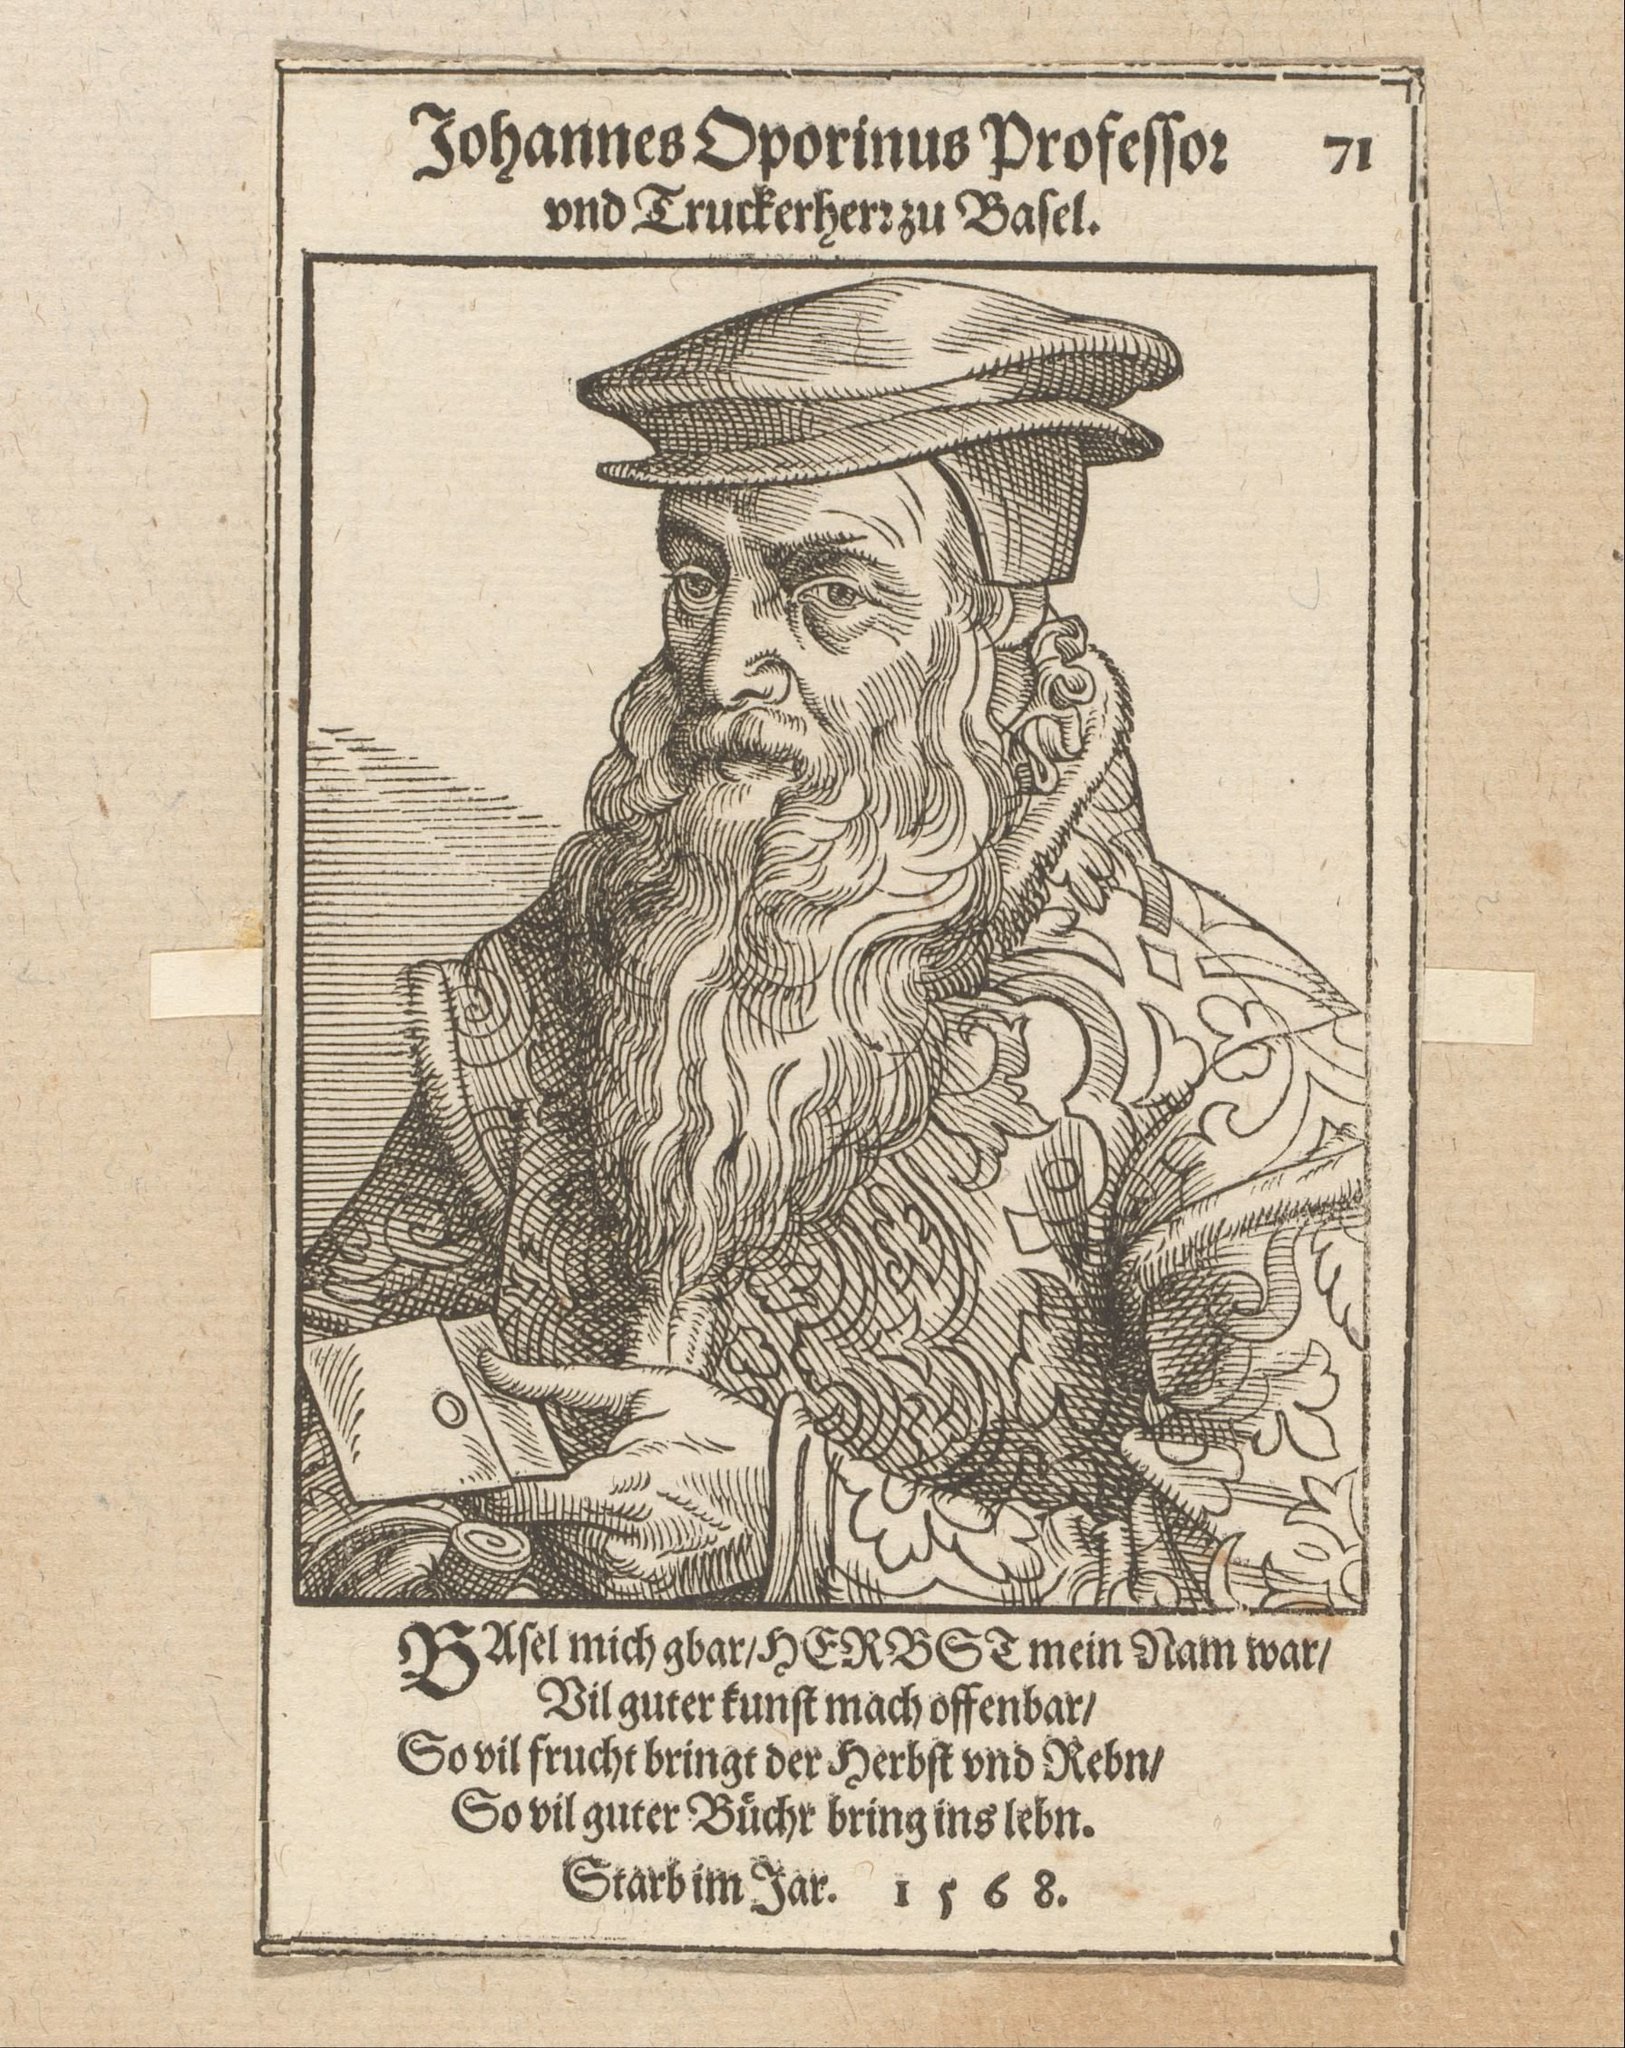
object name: album leaf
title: Portret van Johannes Oporinus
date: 1568-1587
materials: paper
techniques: letterpress printing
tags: printer, publishing, publisher (+ portrait of scholar, scientist), historical persons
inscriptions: collector's mark: Lugt 240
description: Prent gebruikt in: Reusner, Nikolaus. Contrafacturbuch: ware und Lebendige Bildnussen etlicher weitberümbten unnd Hochgelehrten Männer in Teutschland (...). Straatsburg: Bernhard Jobin, 1587.